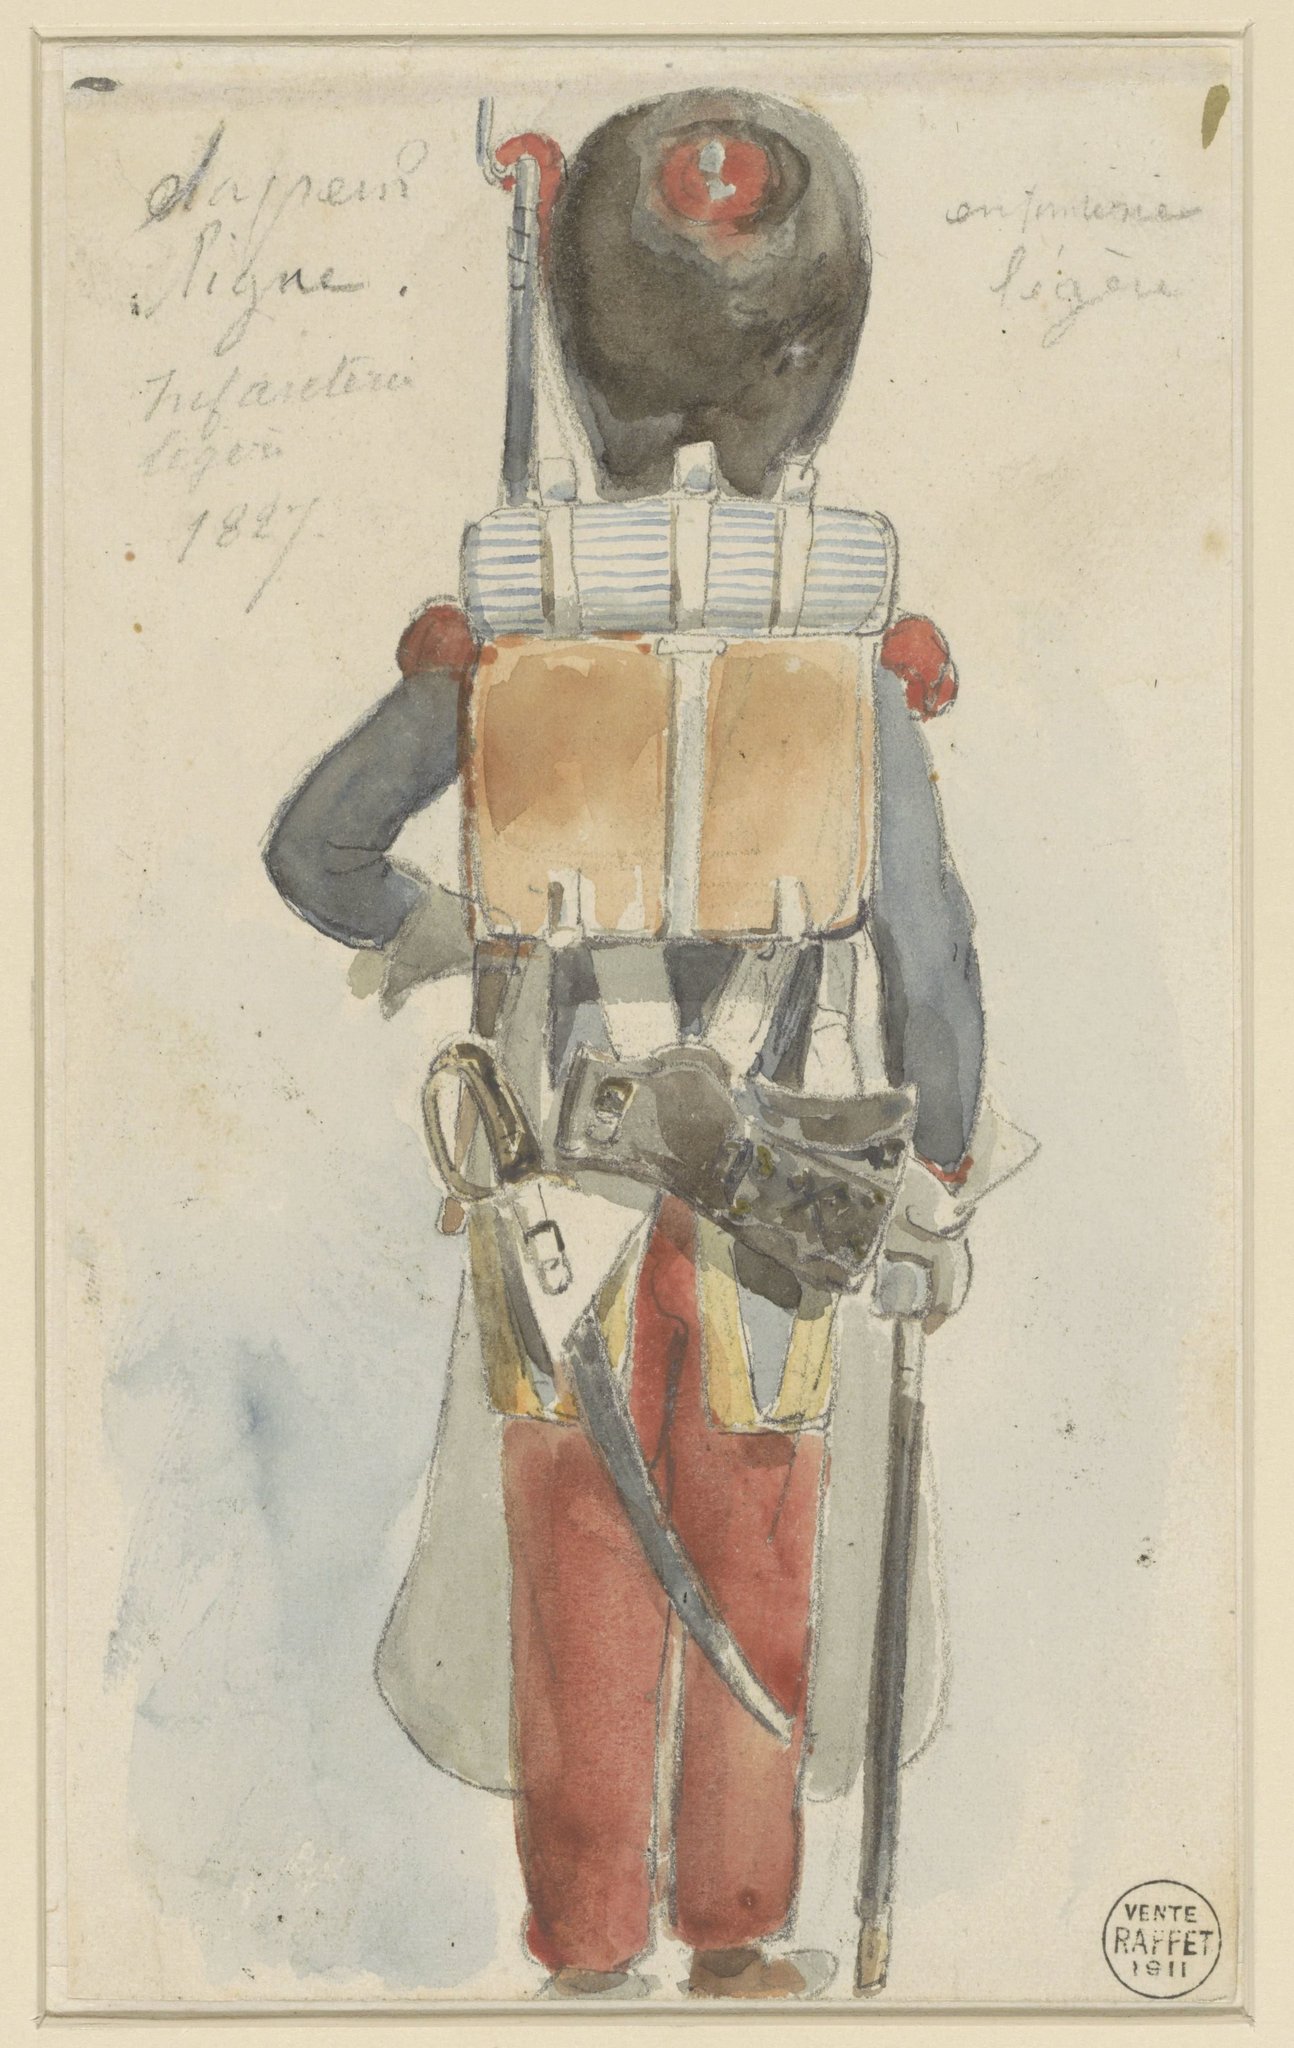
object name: drawing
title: Uniformstudie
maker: denis auguste marie raffet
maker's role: draughtsman, print maker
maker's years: 1804-1860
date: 1827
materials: chalk, paper, watercolor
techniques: brush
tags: (military) uniforms (+ land forces)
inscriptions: date: ‘1827’, stamp: ‘Vente Raffet 1911’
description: Staande figuren van achteren ten voeten uit met berenmut, ransel, sabel en patroontas, geweer aan de schouder en bijl in de rechterhand.